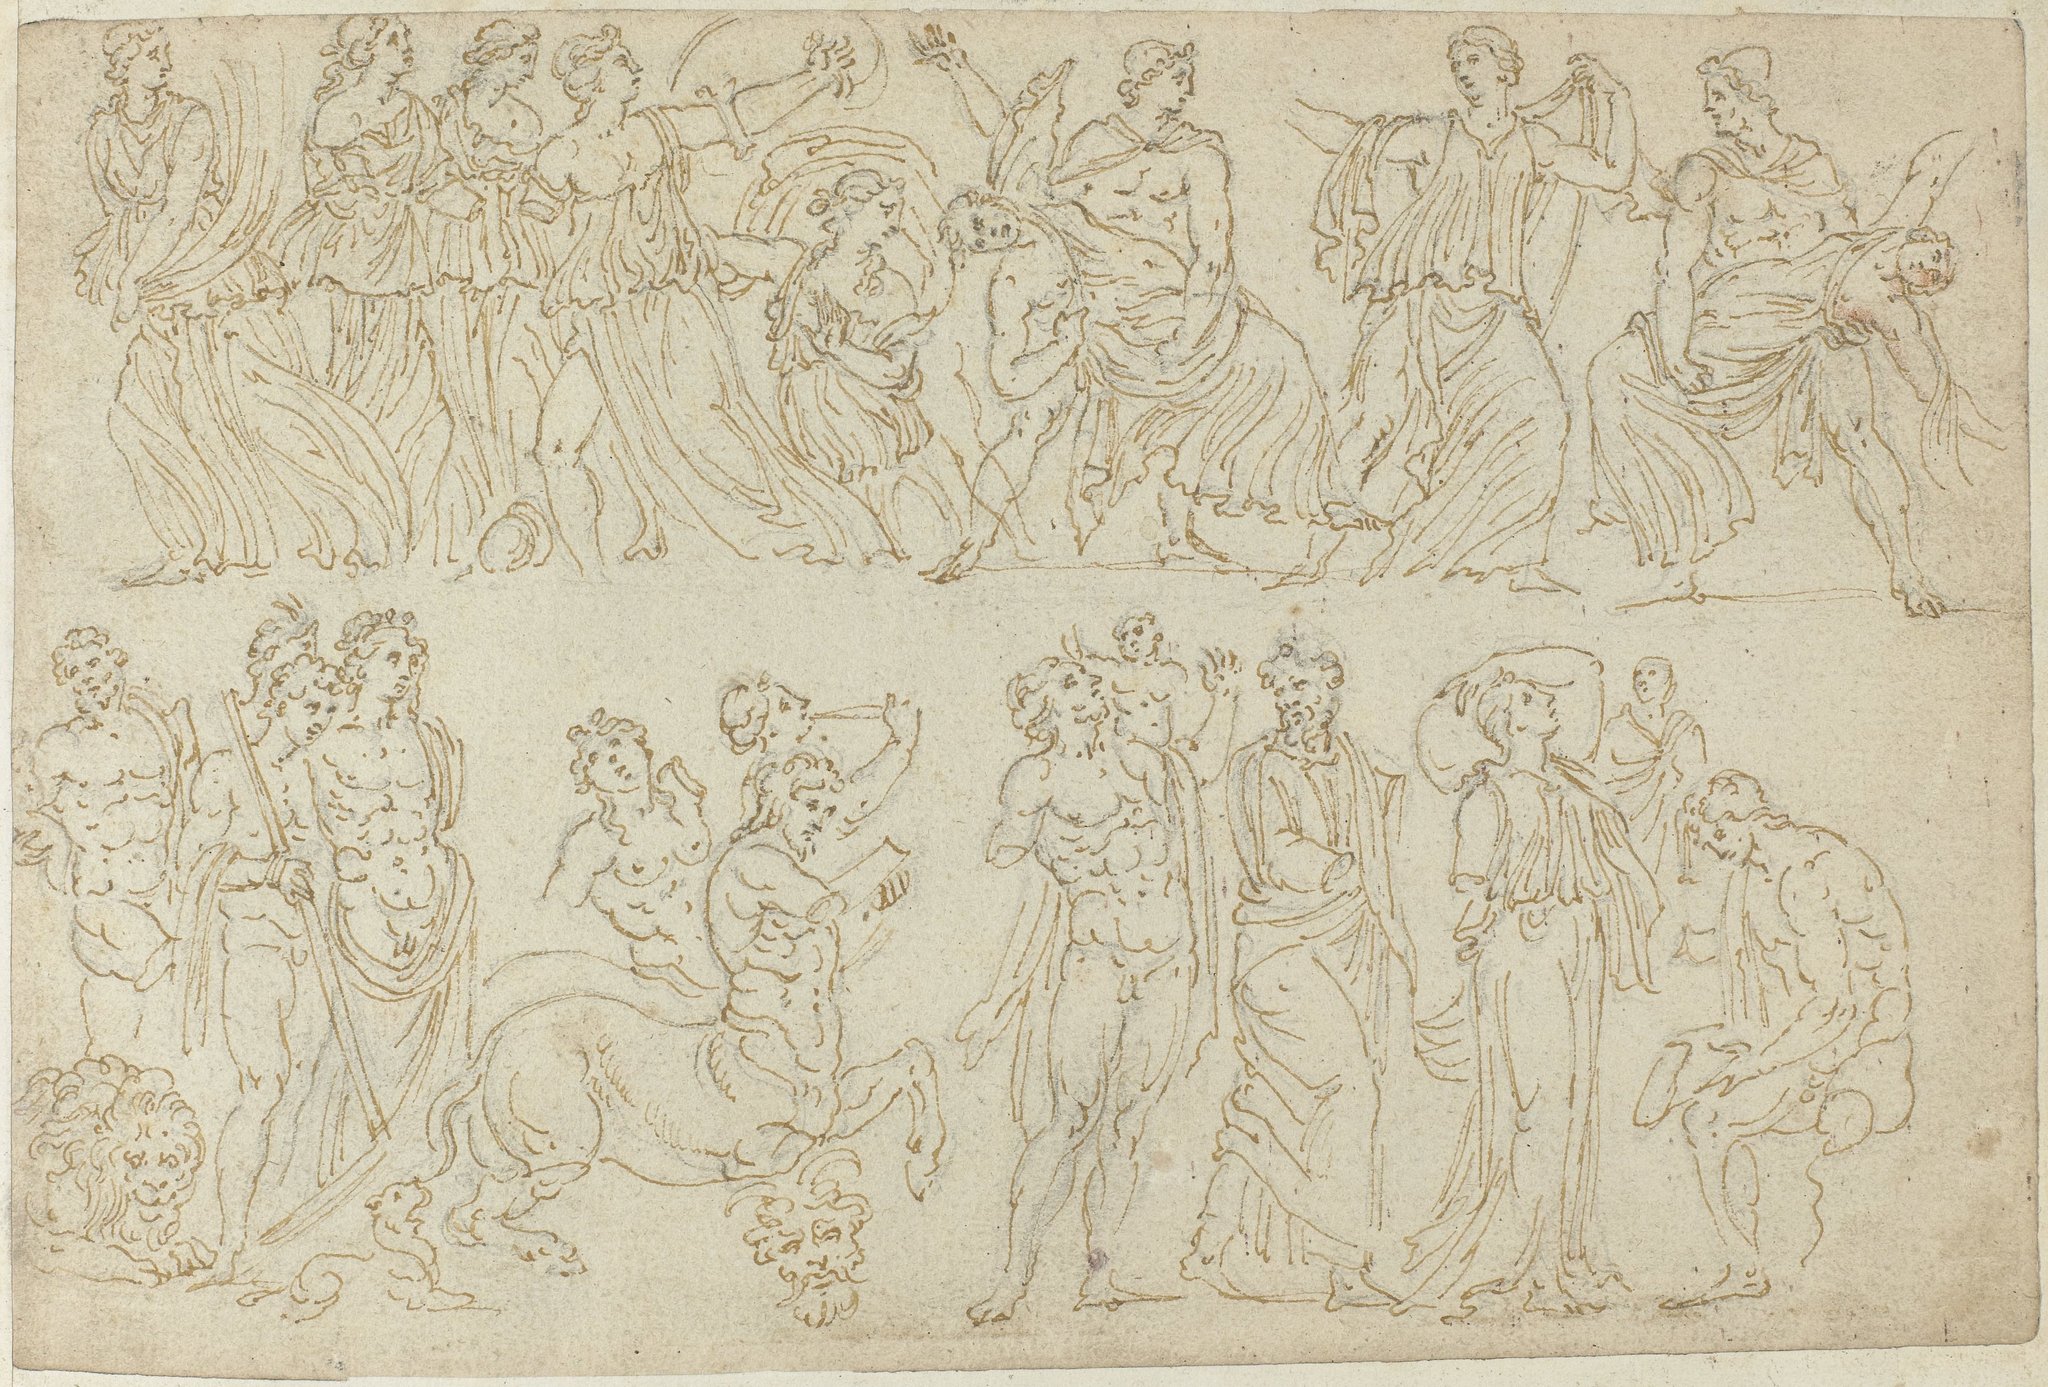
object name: drawing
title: Voorstellingen op sarcofagen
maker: Anonymous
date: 1550-1570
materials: chalk, ink, paper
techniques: brush, pen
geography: low countries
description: Album "Maarten de Vos schetsboek", blad 2v(12).